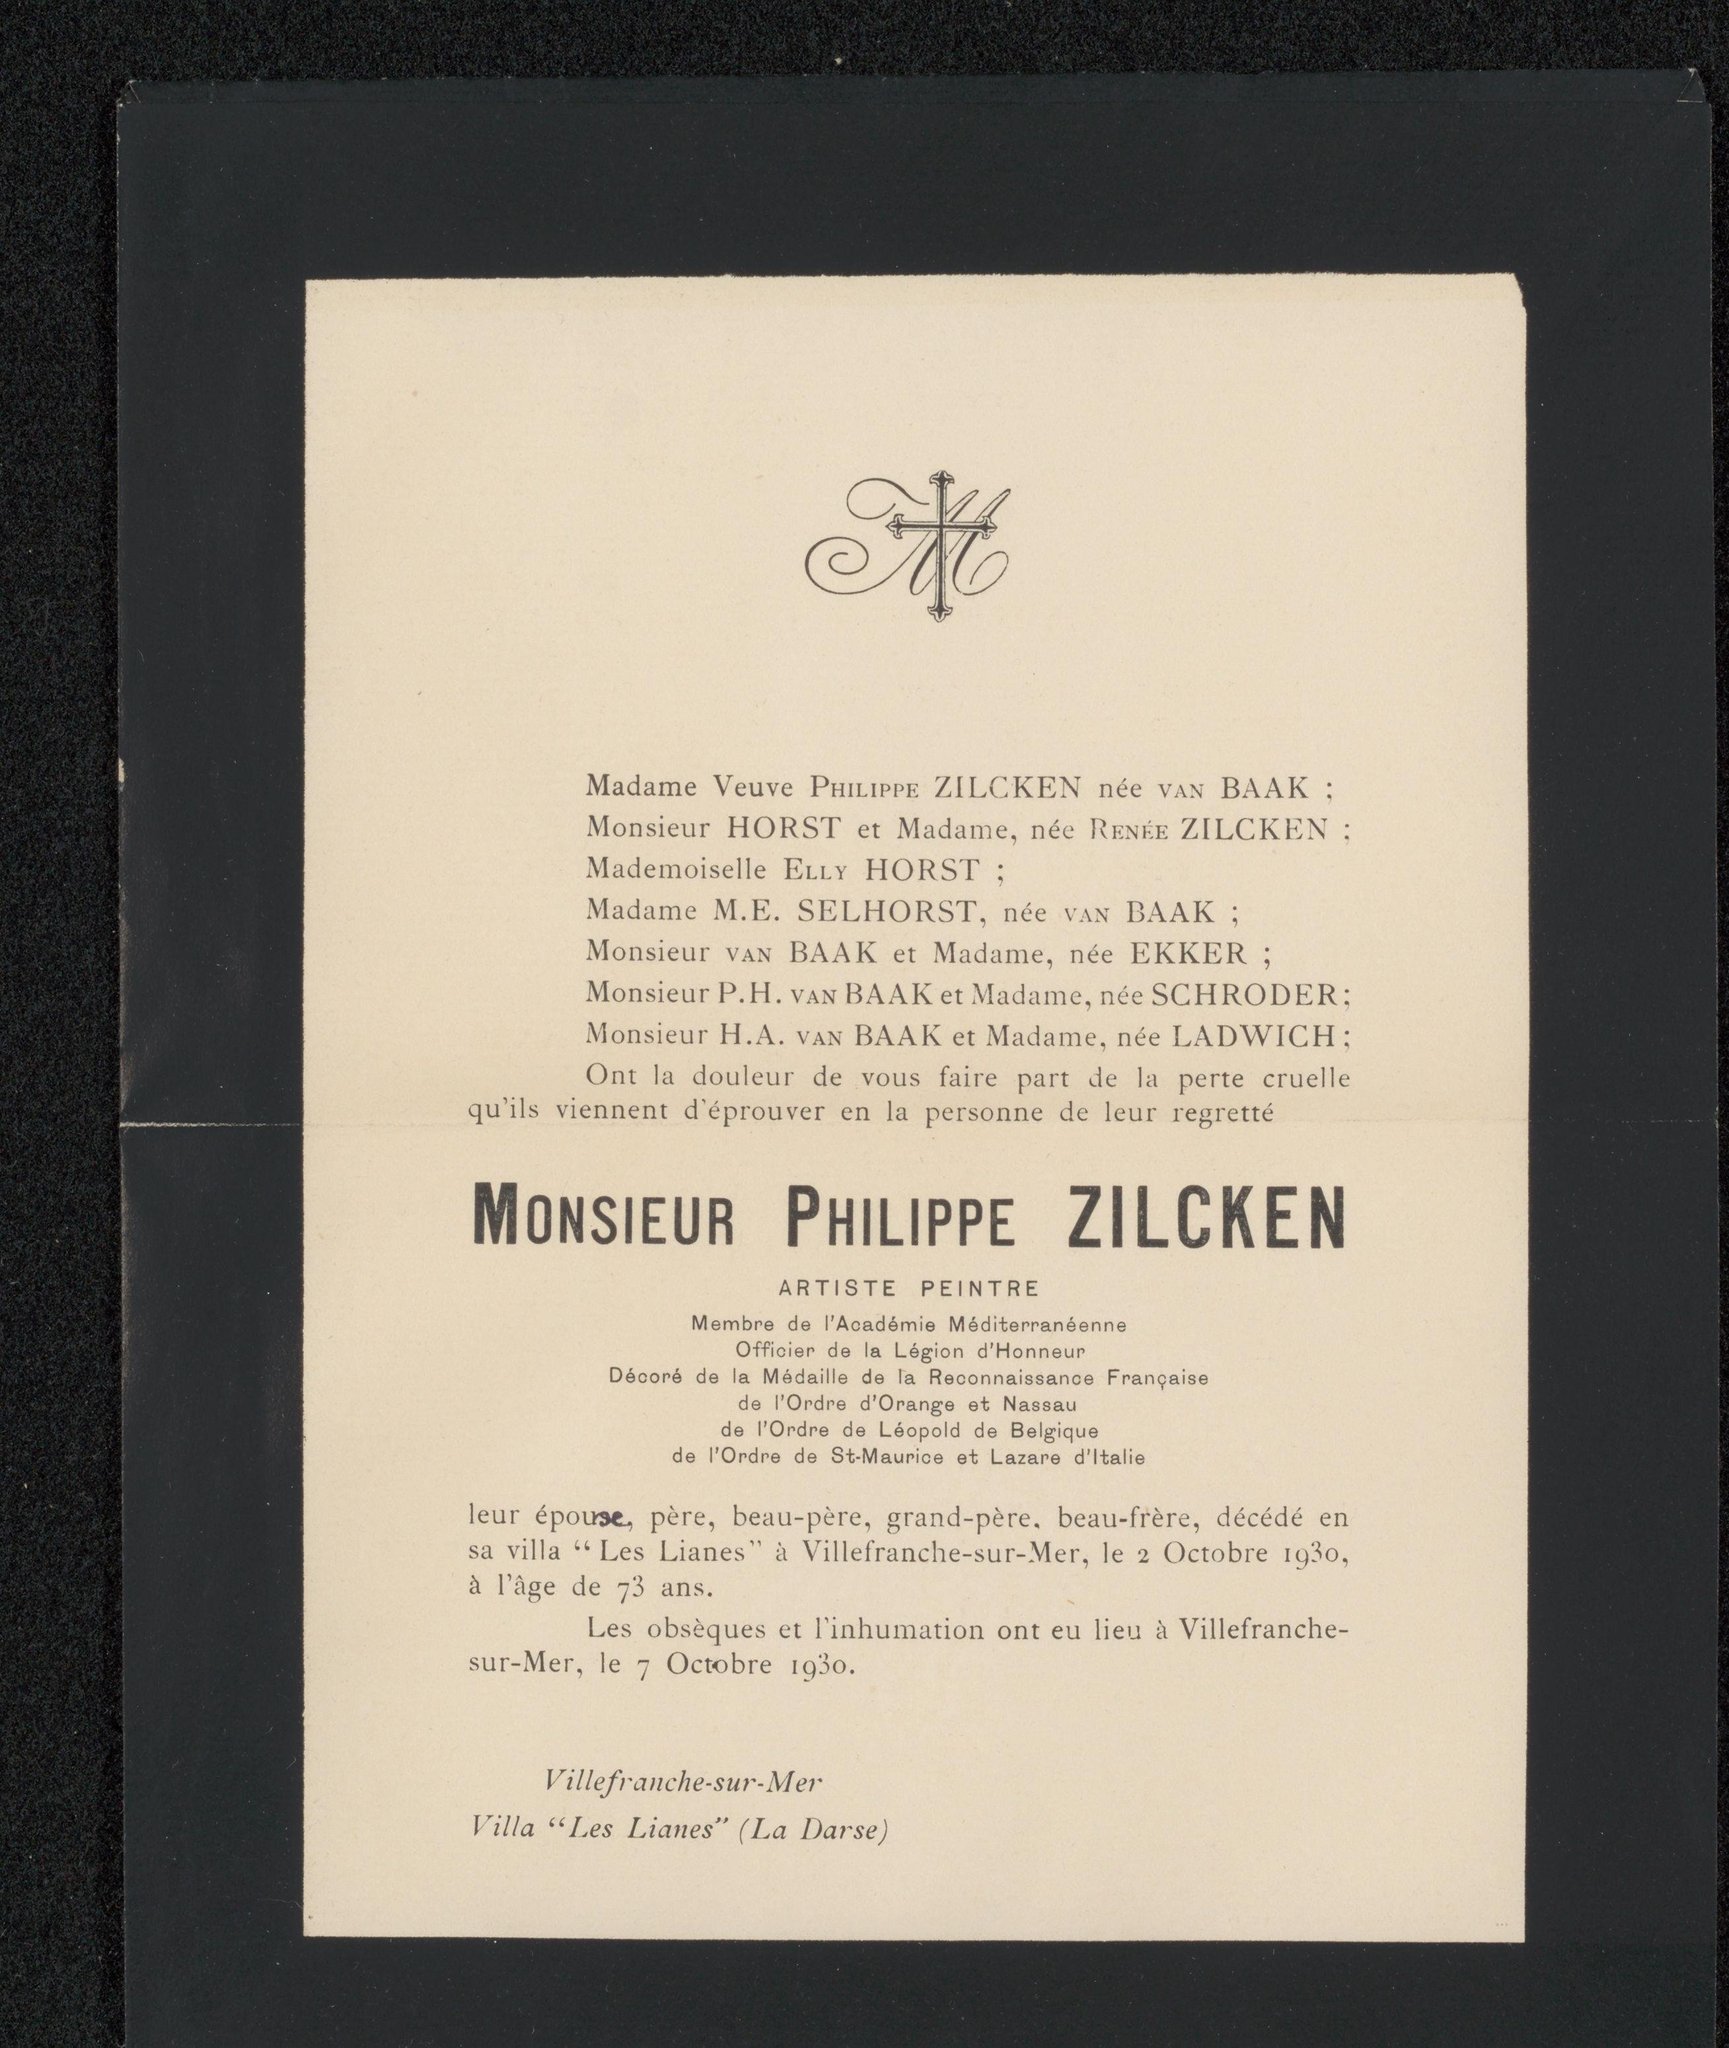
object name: overlijdensbericht, overlijdensadvertentie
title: Overlijdensbericht uit archief Philip Zilcken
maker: henriette wilhelmina van baak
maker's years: 1868-1943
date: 1930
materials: paper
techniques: printing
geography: nice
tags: the hague, painter, draughtsman, philip zilcken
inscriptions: watermark